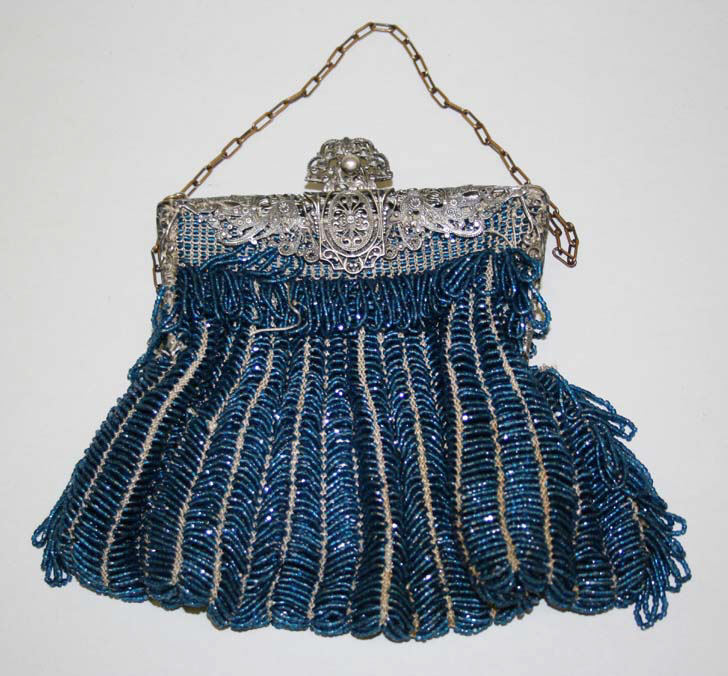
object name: purse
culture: italian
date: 1895-1900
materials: glass, metal, silk